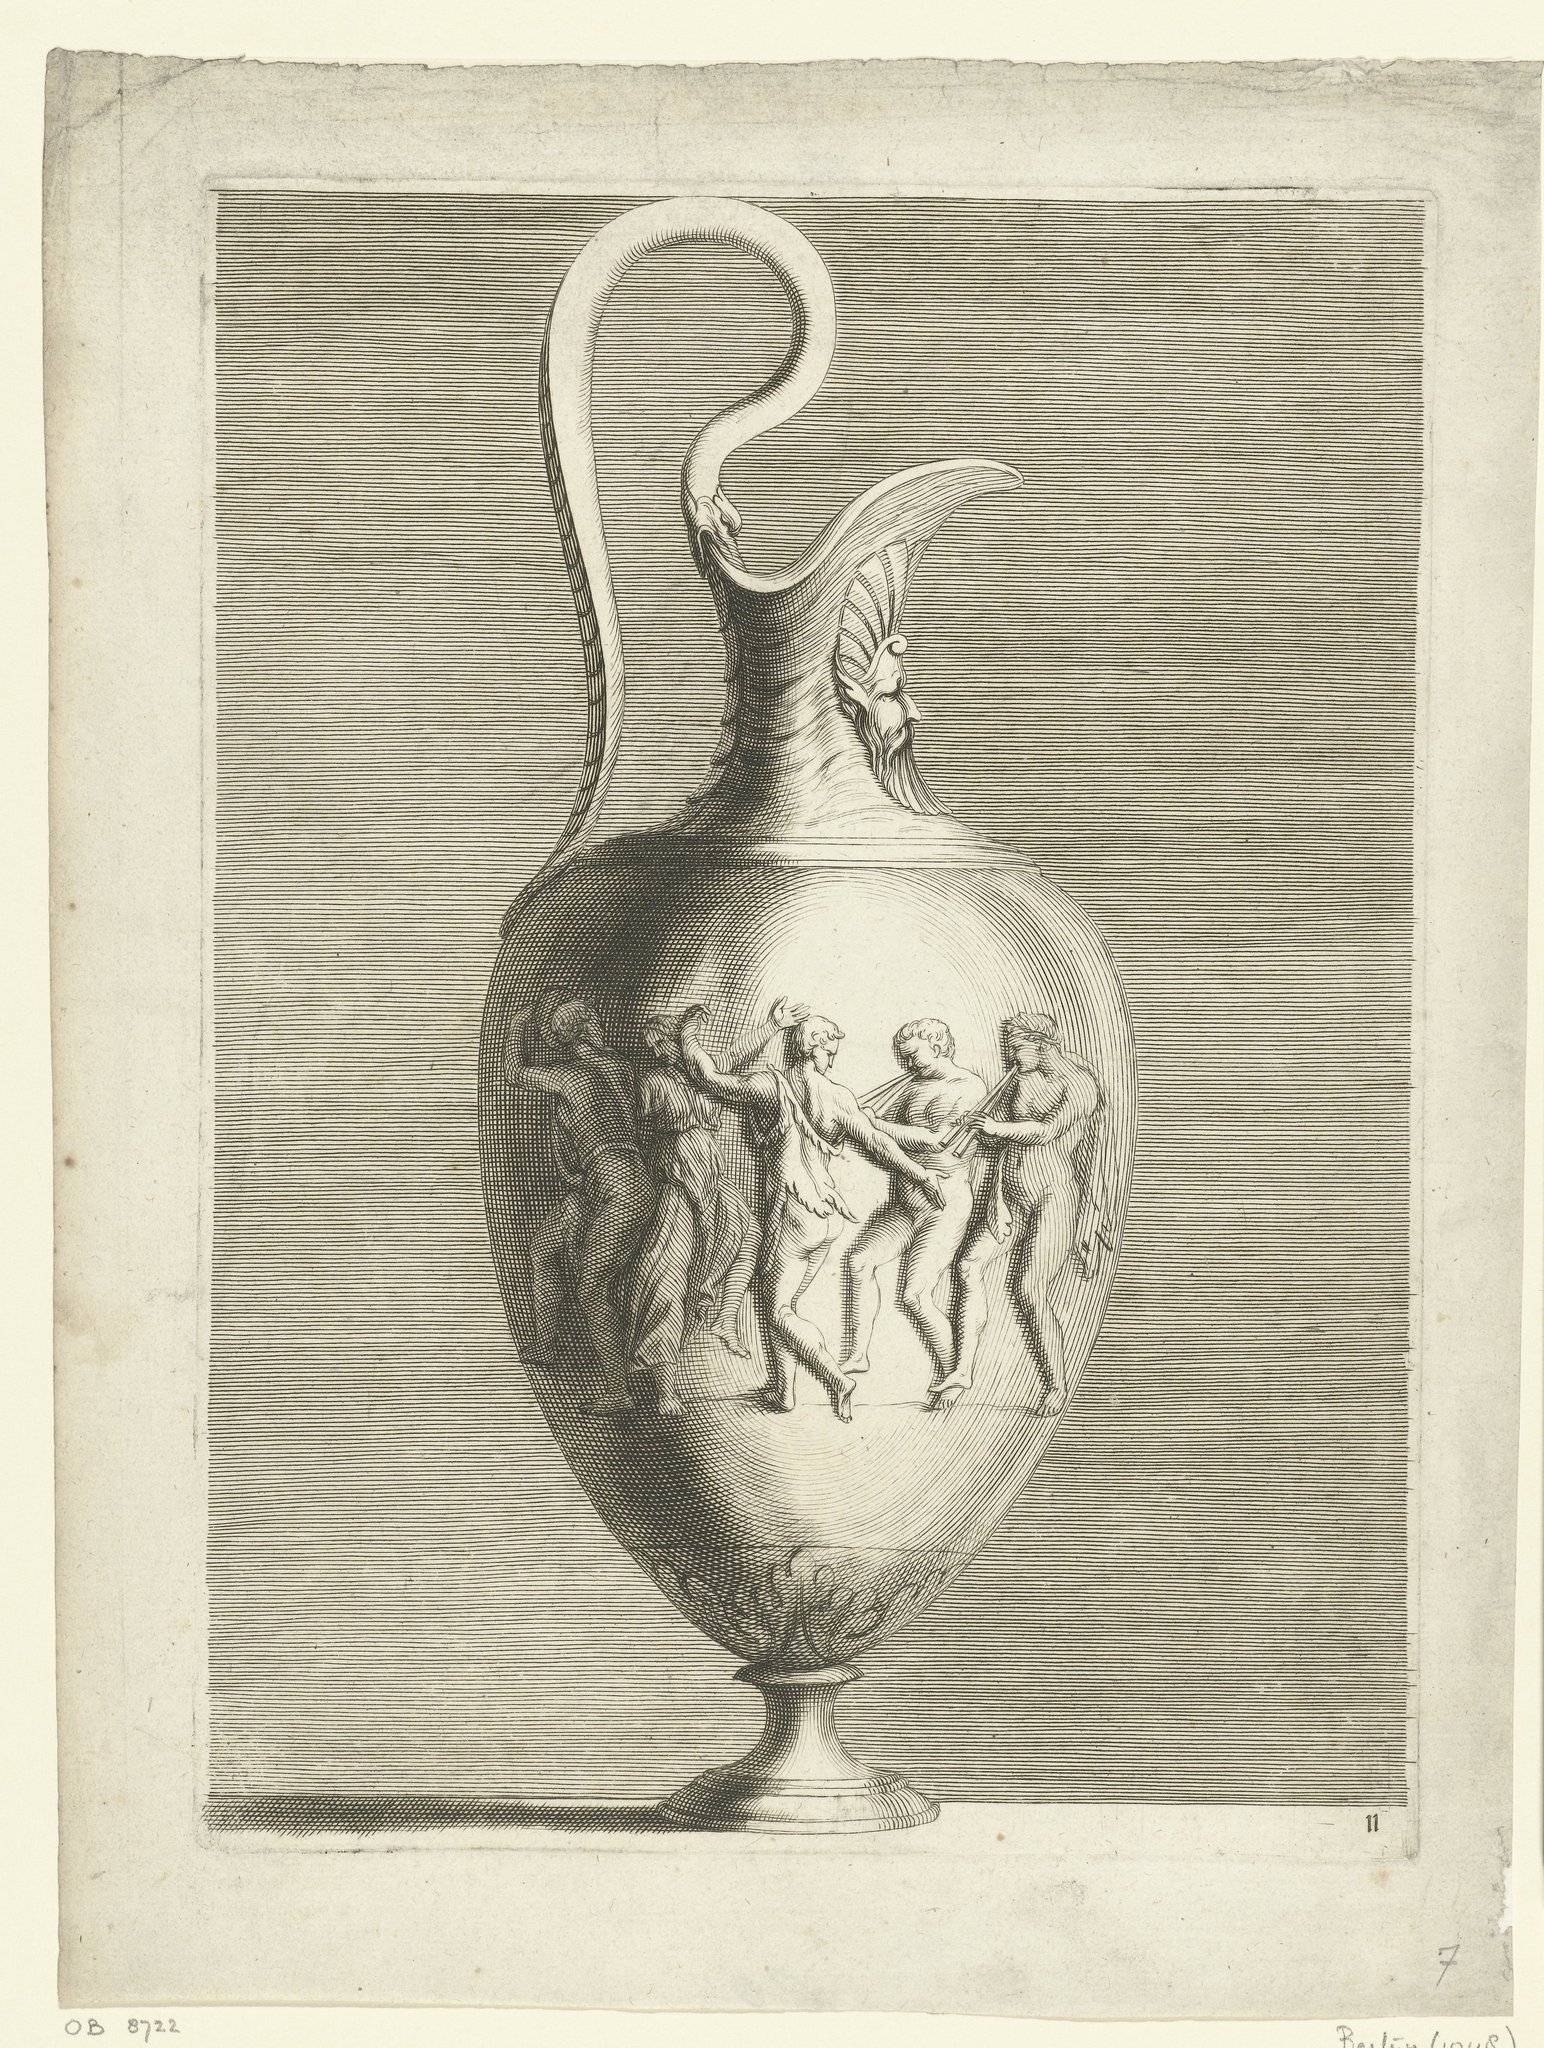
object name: ornament print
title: Livre de Vases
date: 1657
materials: paper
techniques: engraving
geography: paris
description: Het handvat loopt uit in een slangenkop, onder de tuit is een masker. Blad 11 uit serie van 24 bladen, genummerd: 1-21, 23-25.